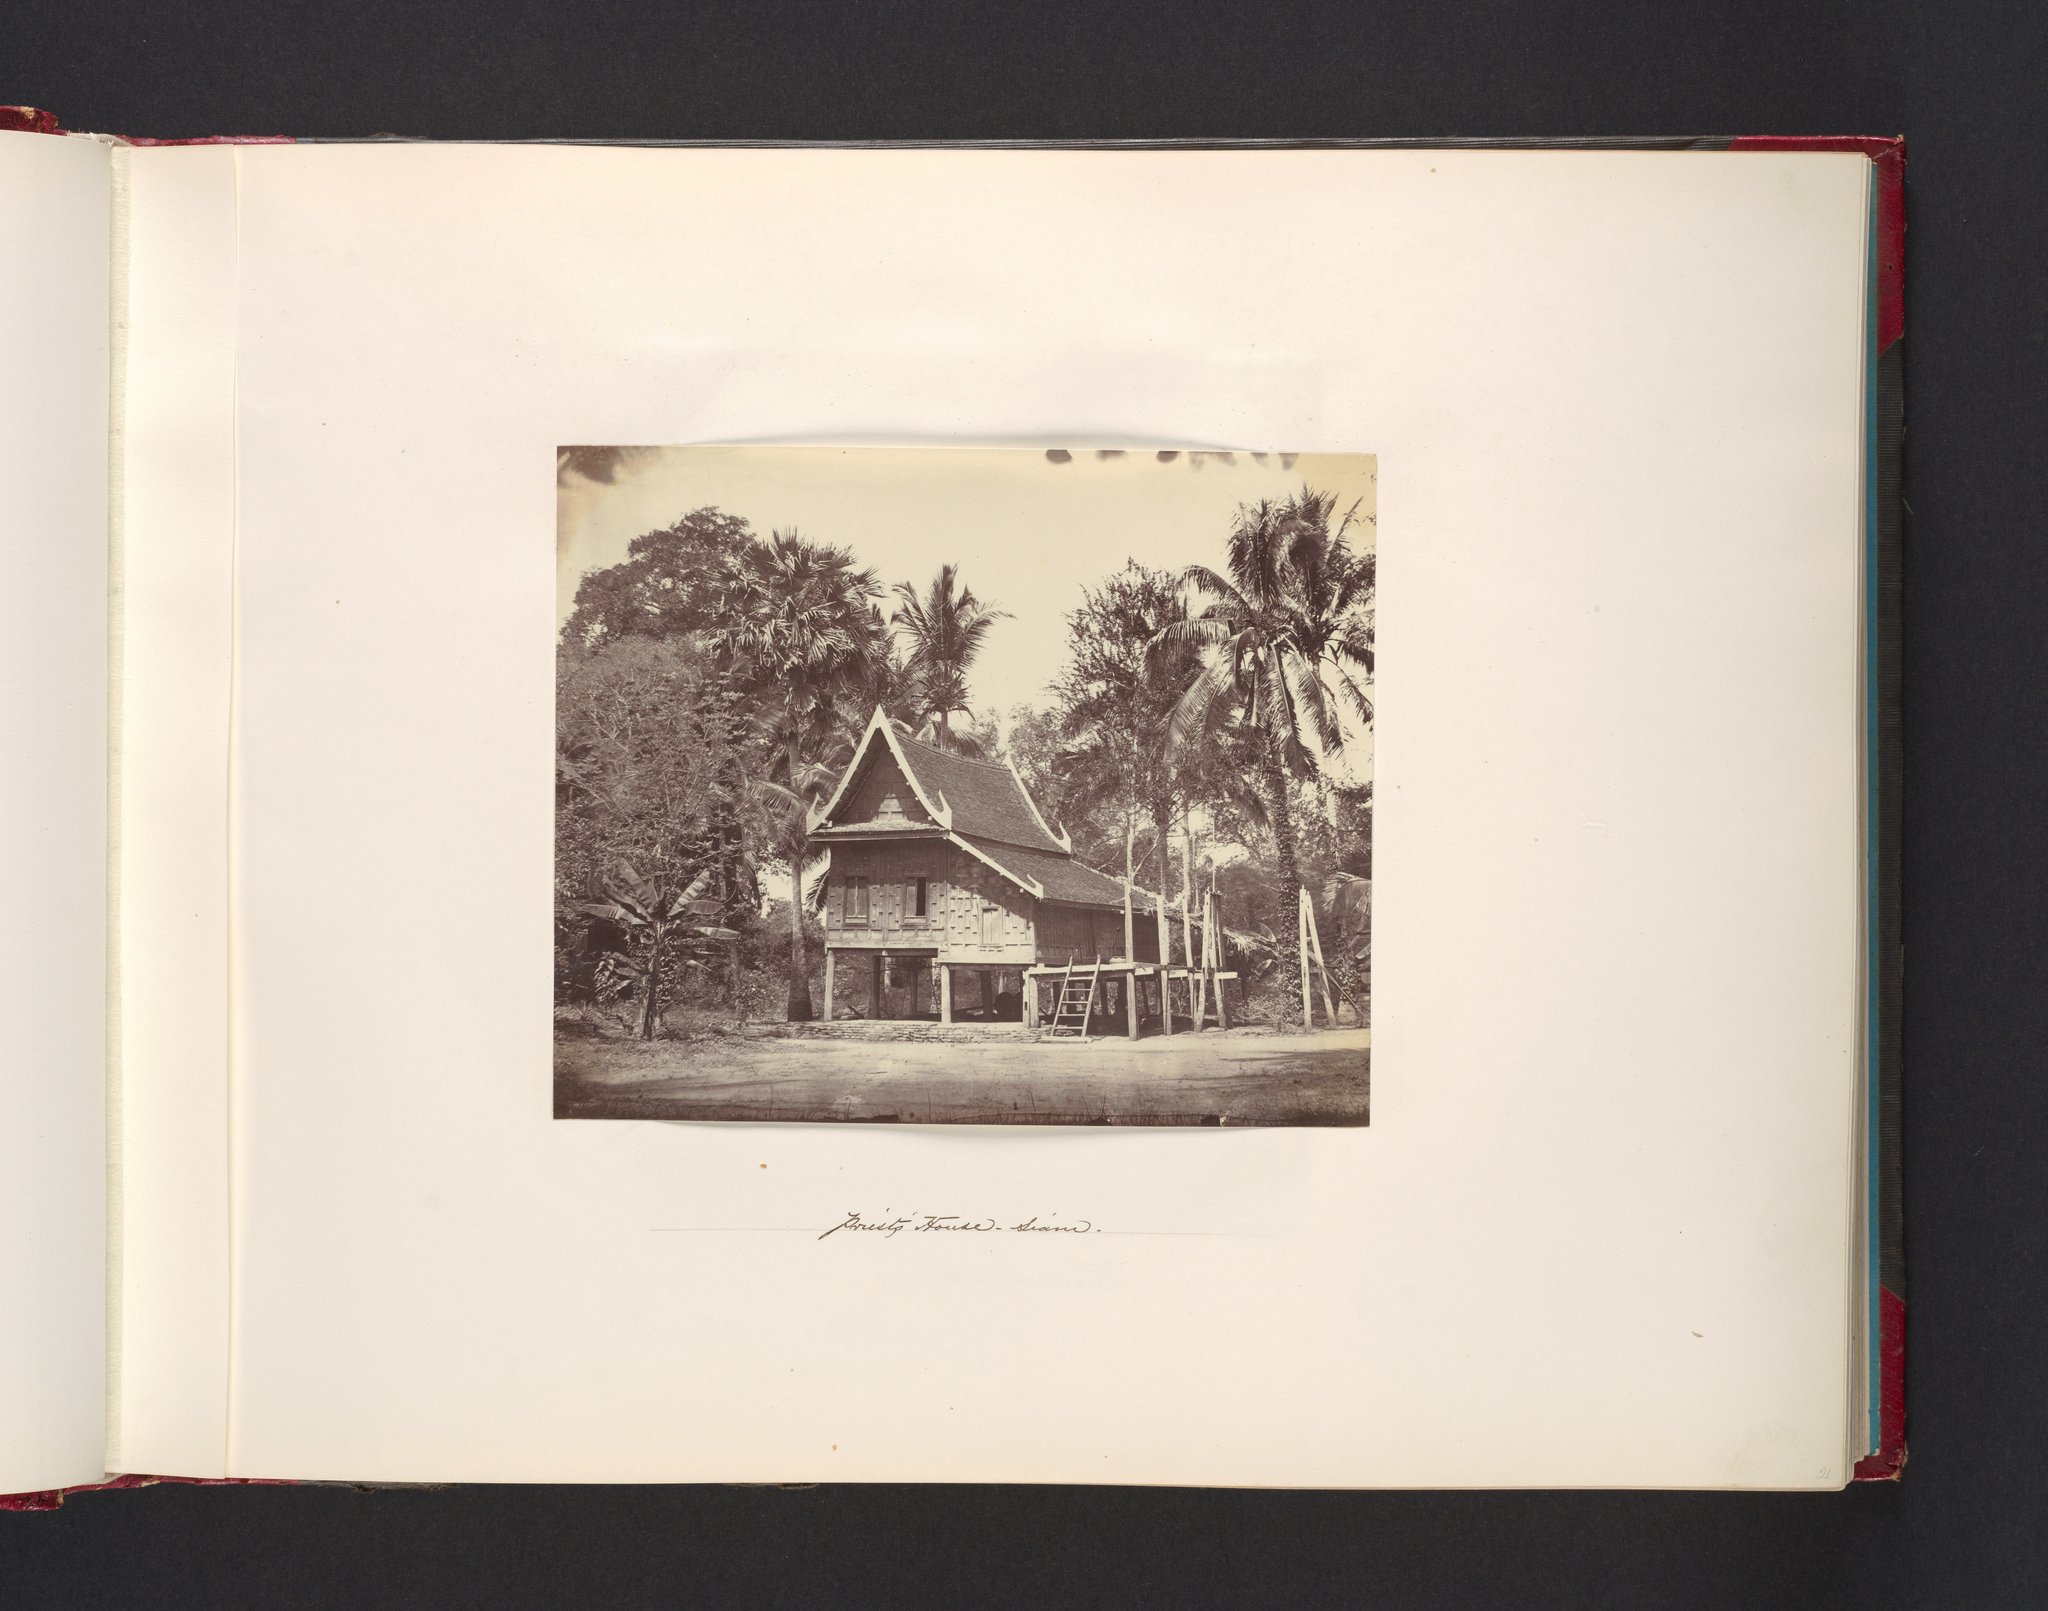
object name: photograph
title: Priests House, Siam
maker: john thomson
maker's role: artist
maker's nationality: british, scottish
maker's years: 1837-1921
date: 1865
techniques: albumen silver print, glass negative